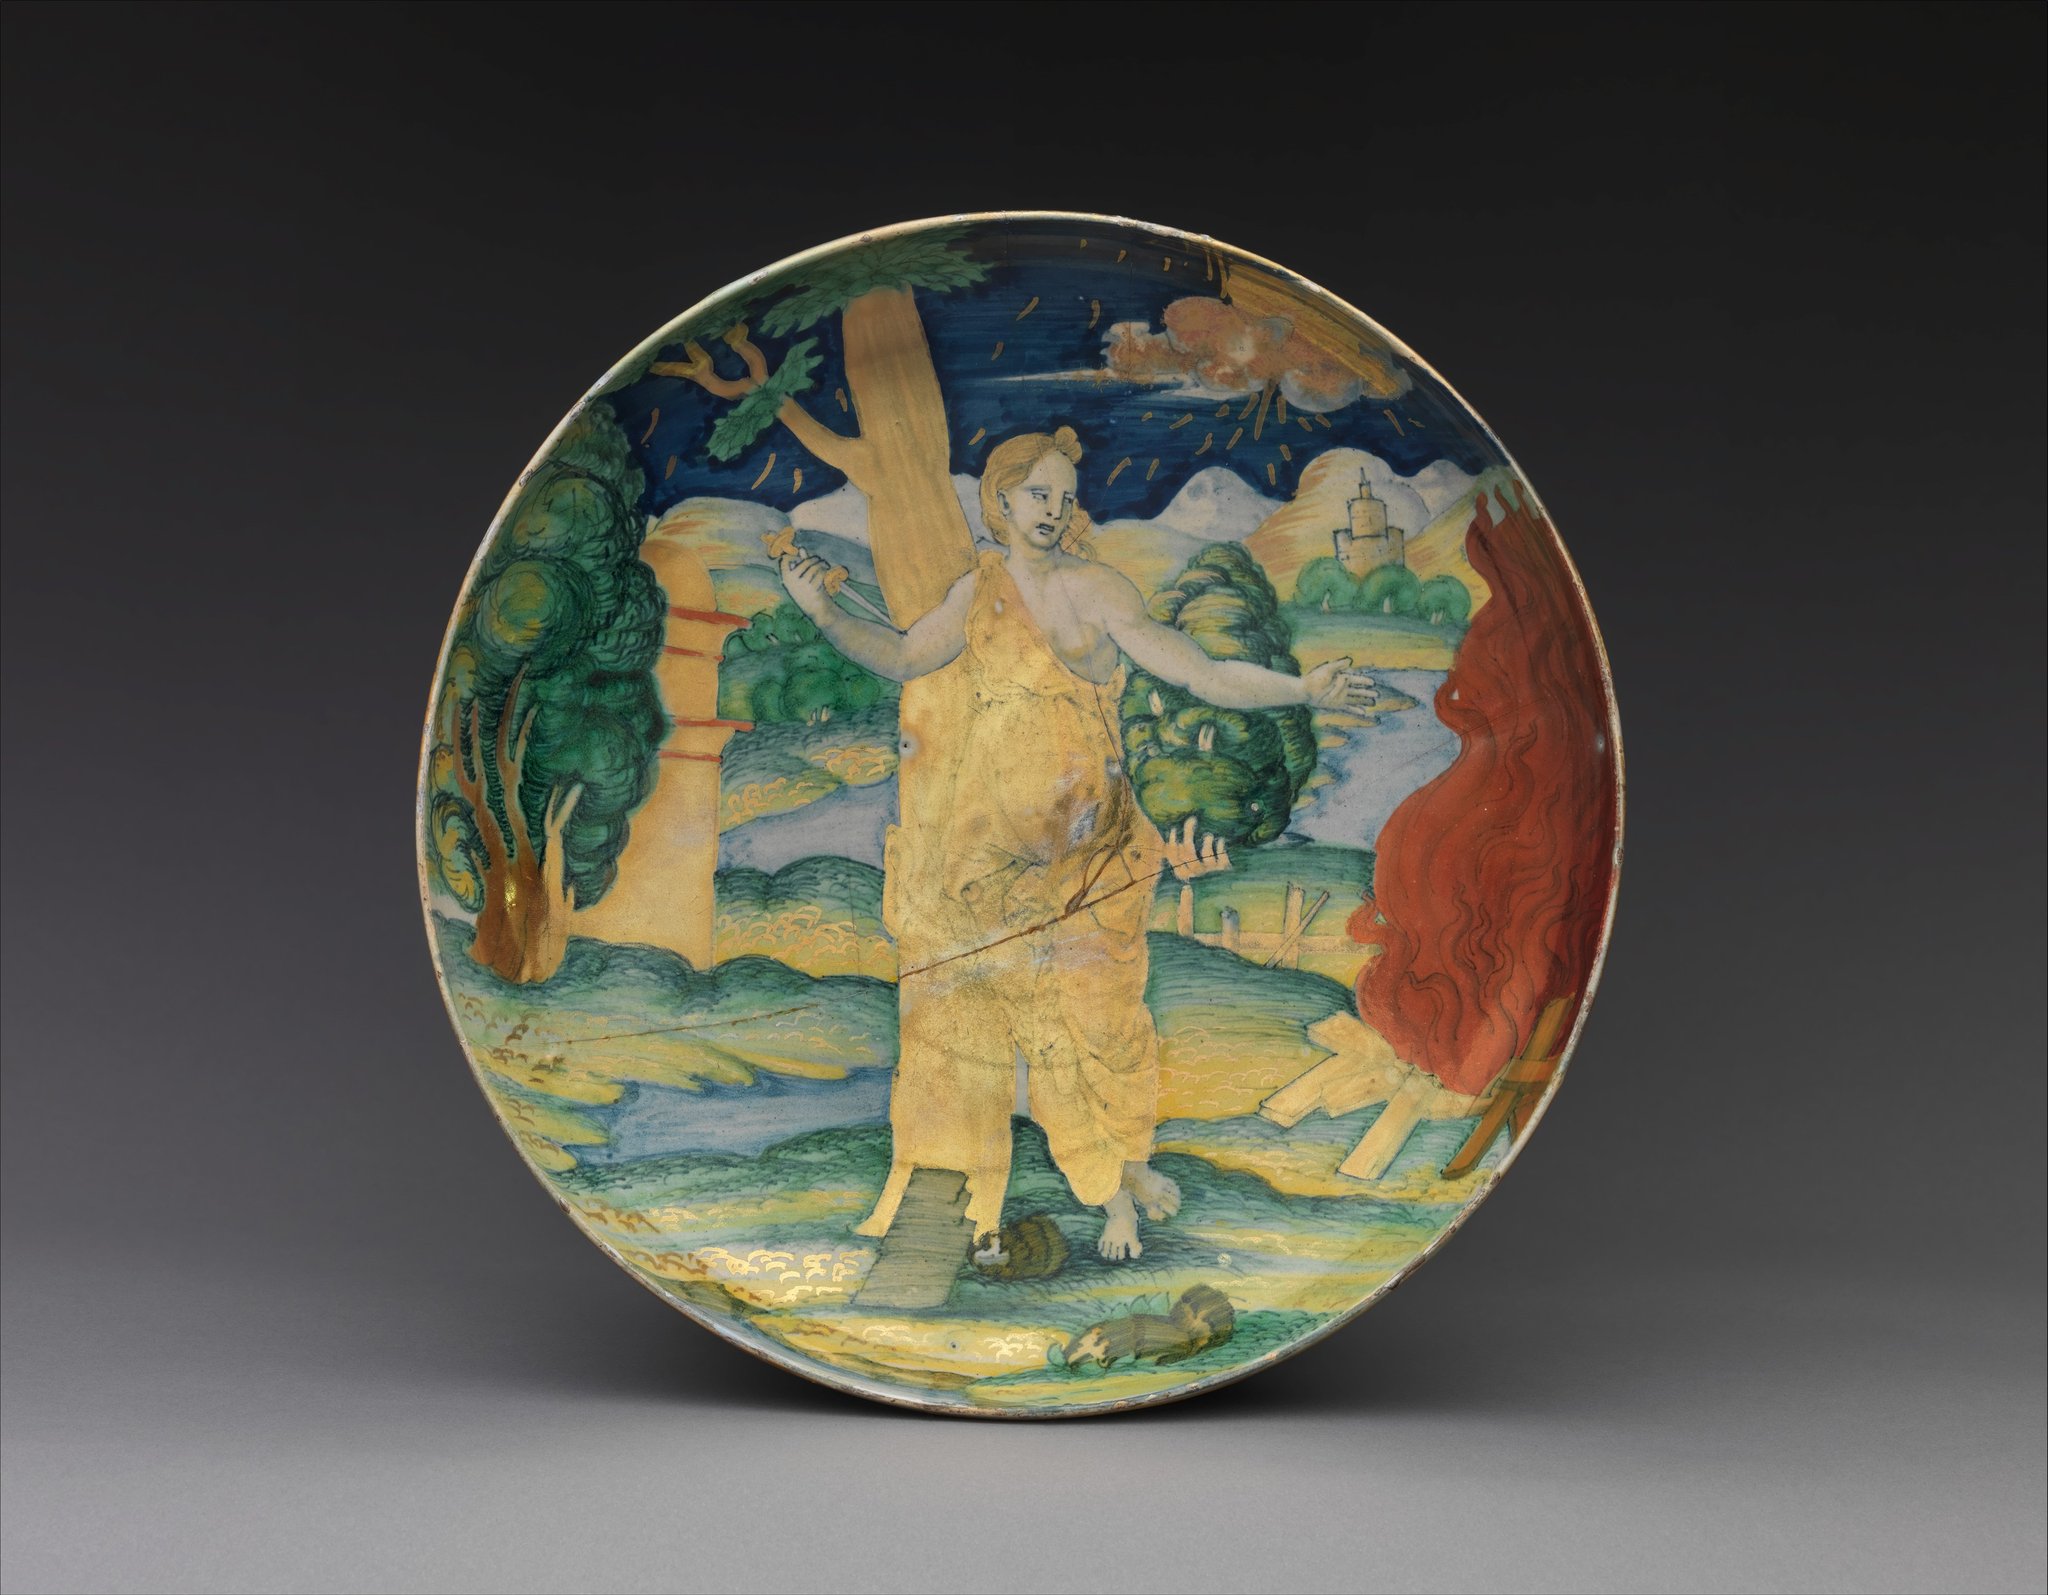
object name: tazza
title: Shallow bowl depicting the Suicide of Dido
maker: maestro giorgio andreoli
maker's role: decorator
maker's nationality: italian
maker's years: 1500-1550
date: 1522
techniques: maiolica, glazing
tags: knives,men,trees